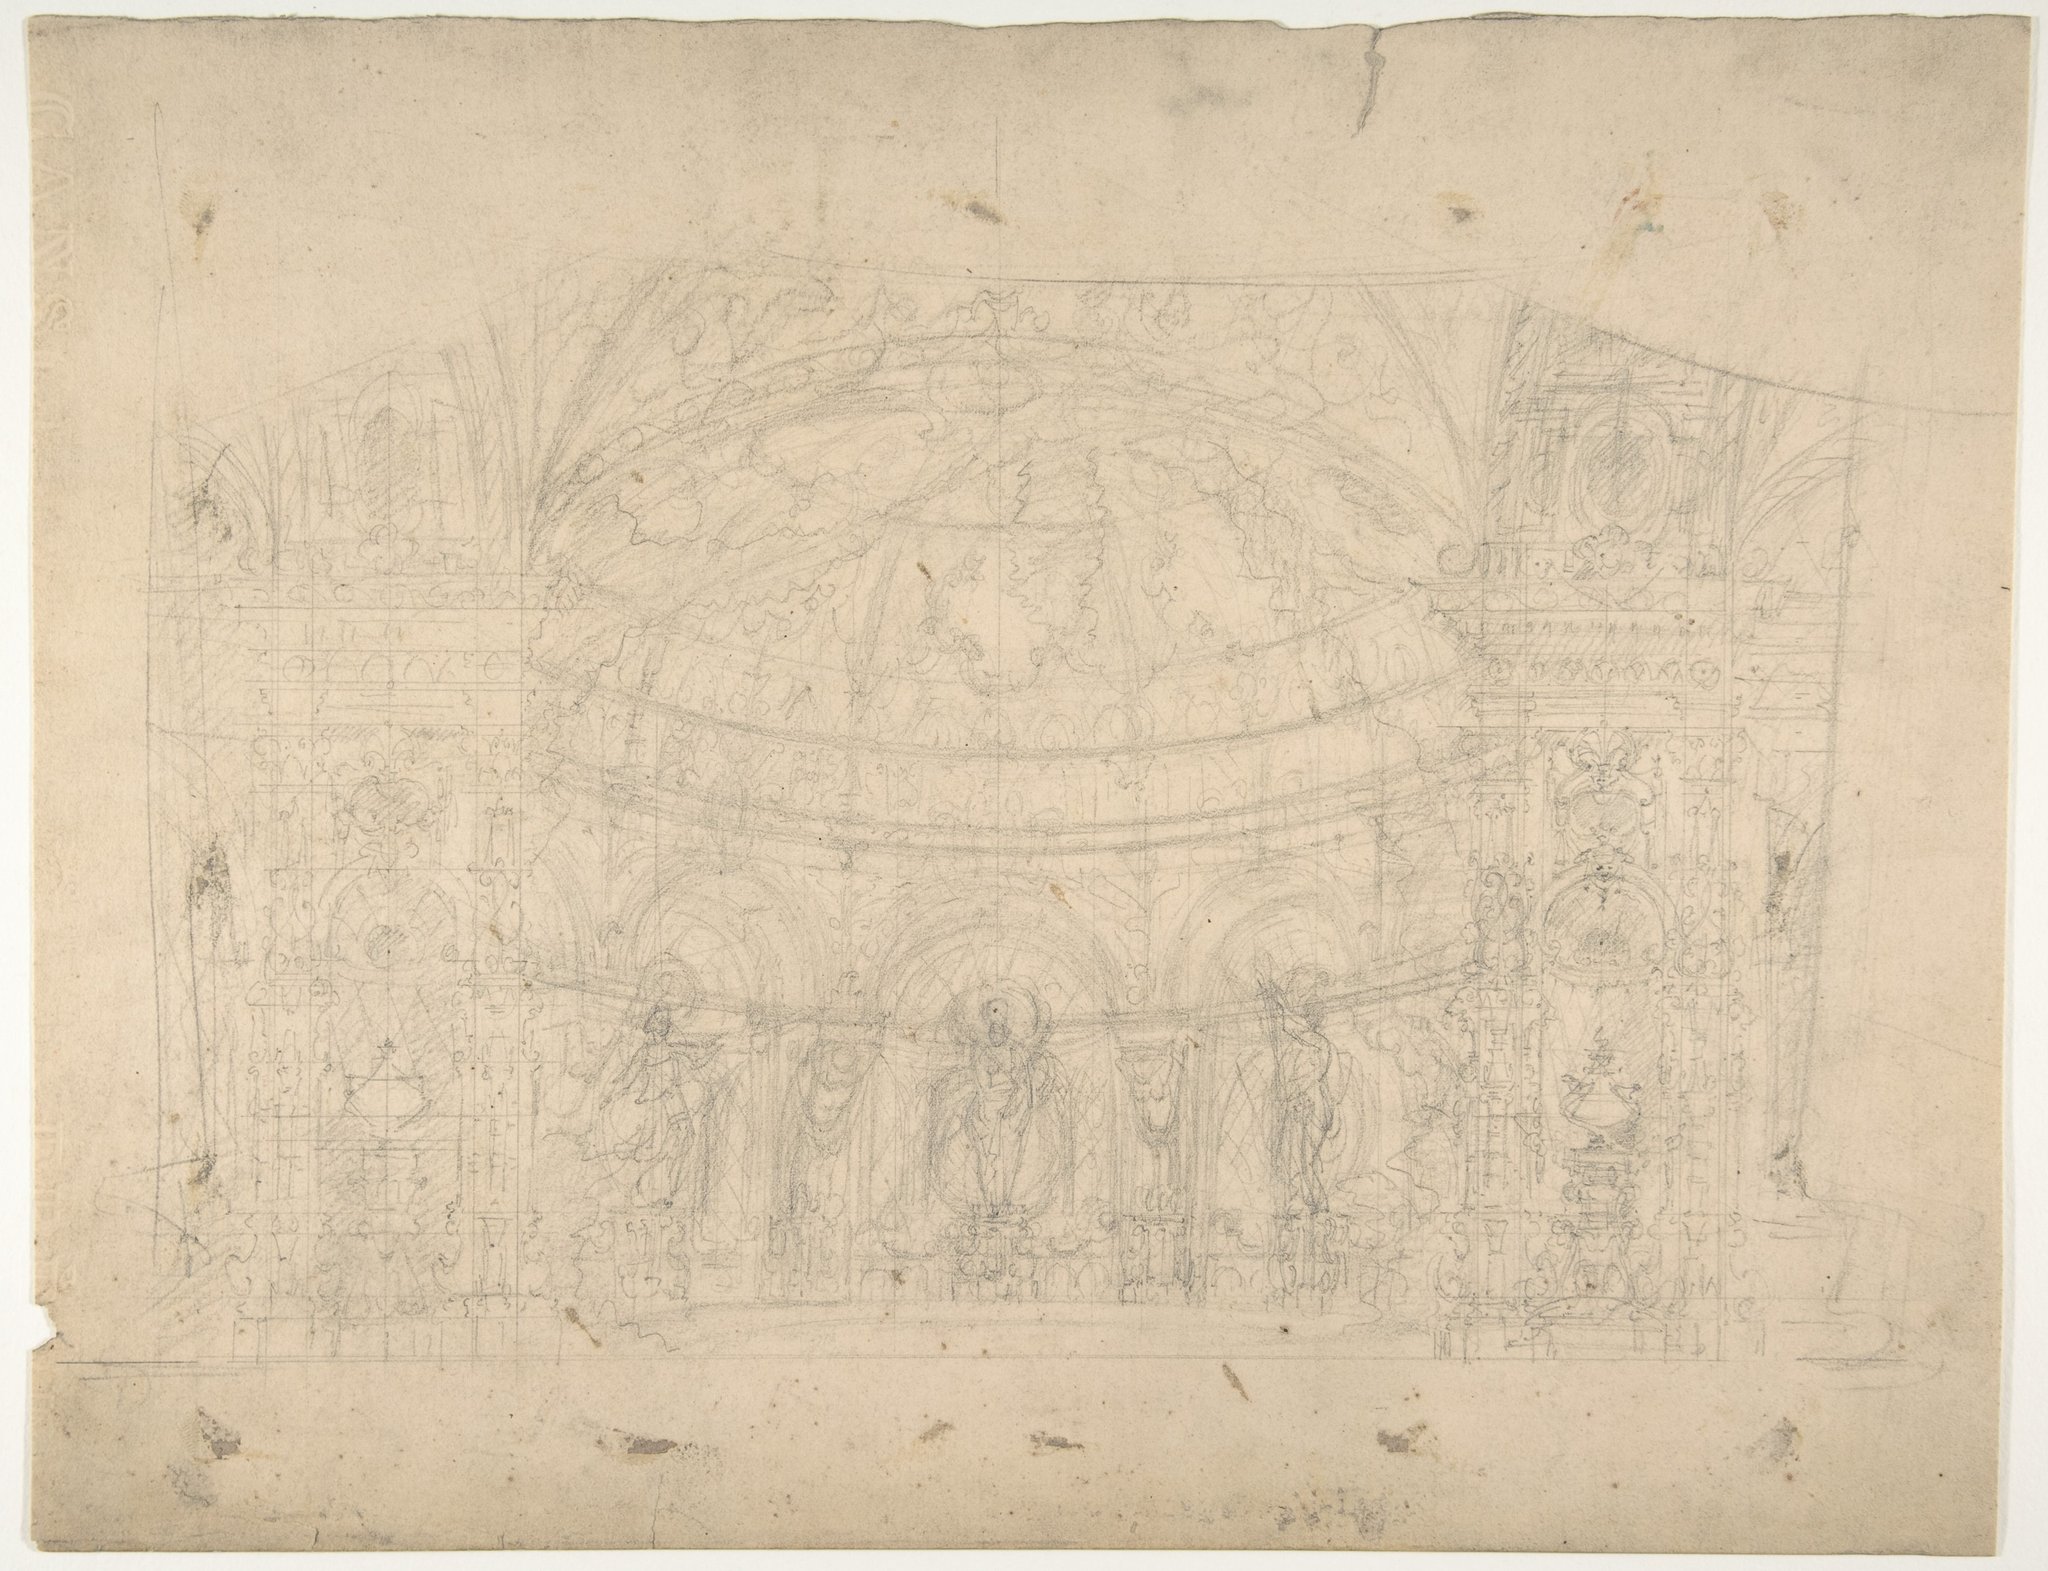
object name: drawing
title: Design for a Stage Set at the Opéra, Paris: Domed Interior (recto); Sketches for Dome and Doors (verso)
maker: eugène cicéri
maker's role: artist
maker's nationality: french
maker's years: 1813-1890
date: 1830-1890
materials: graphite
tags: stage design